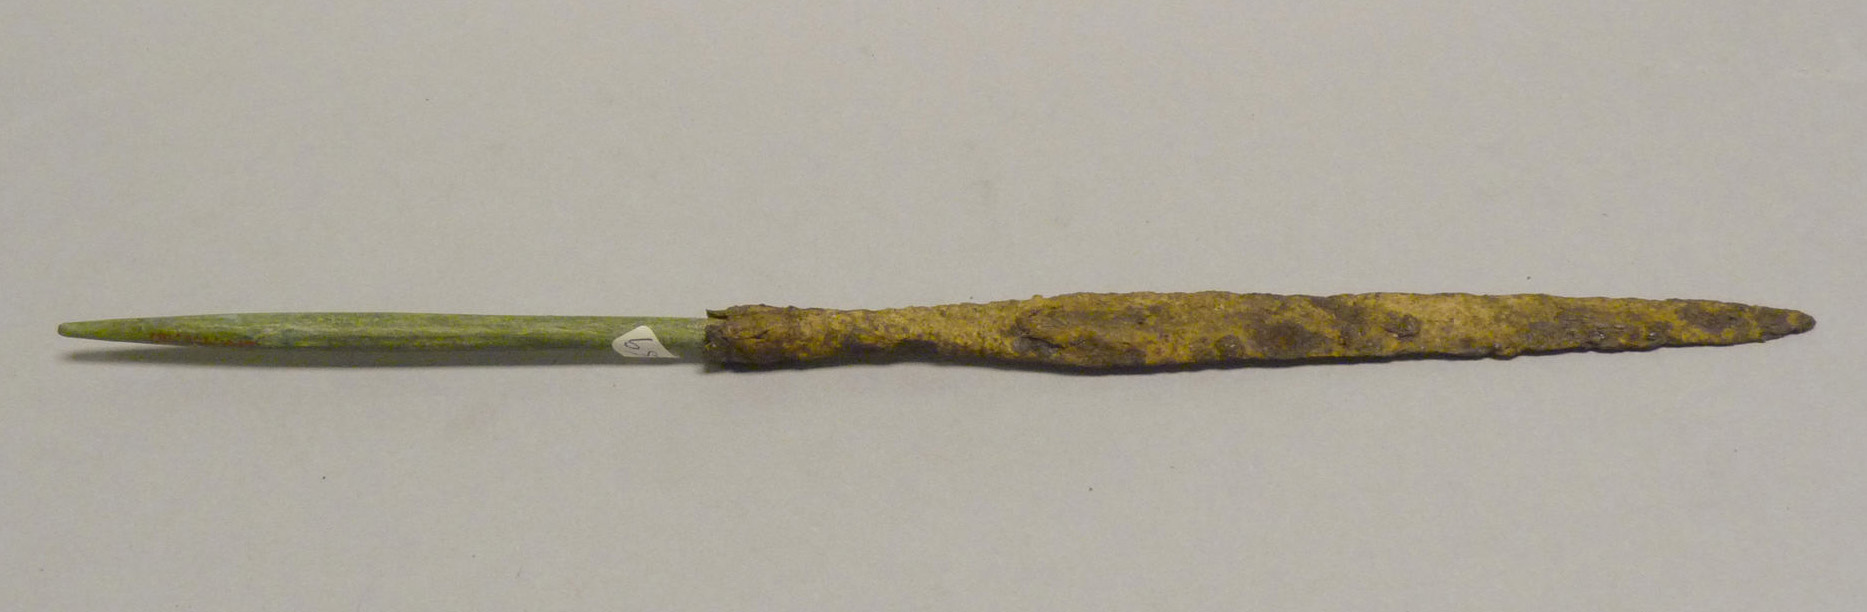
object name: spearhead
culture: indonesian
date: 500 BCE-300 CE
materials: bronze